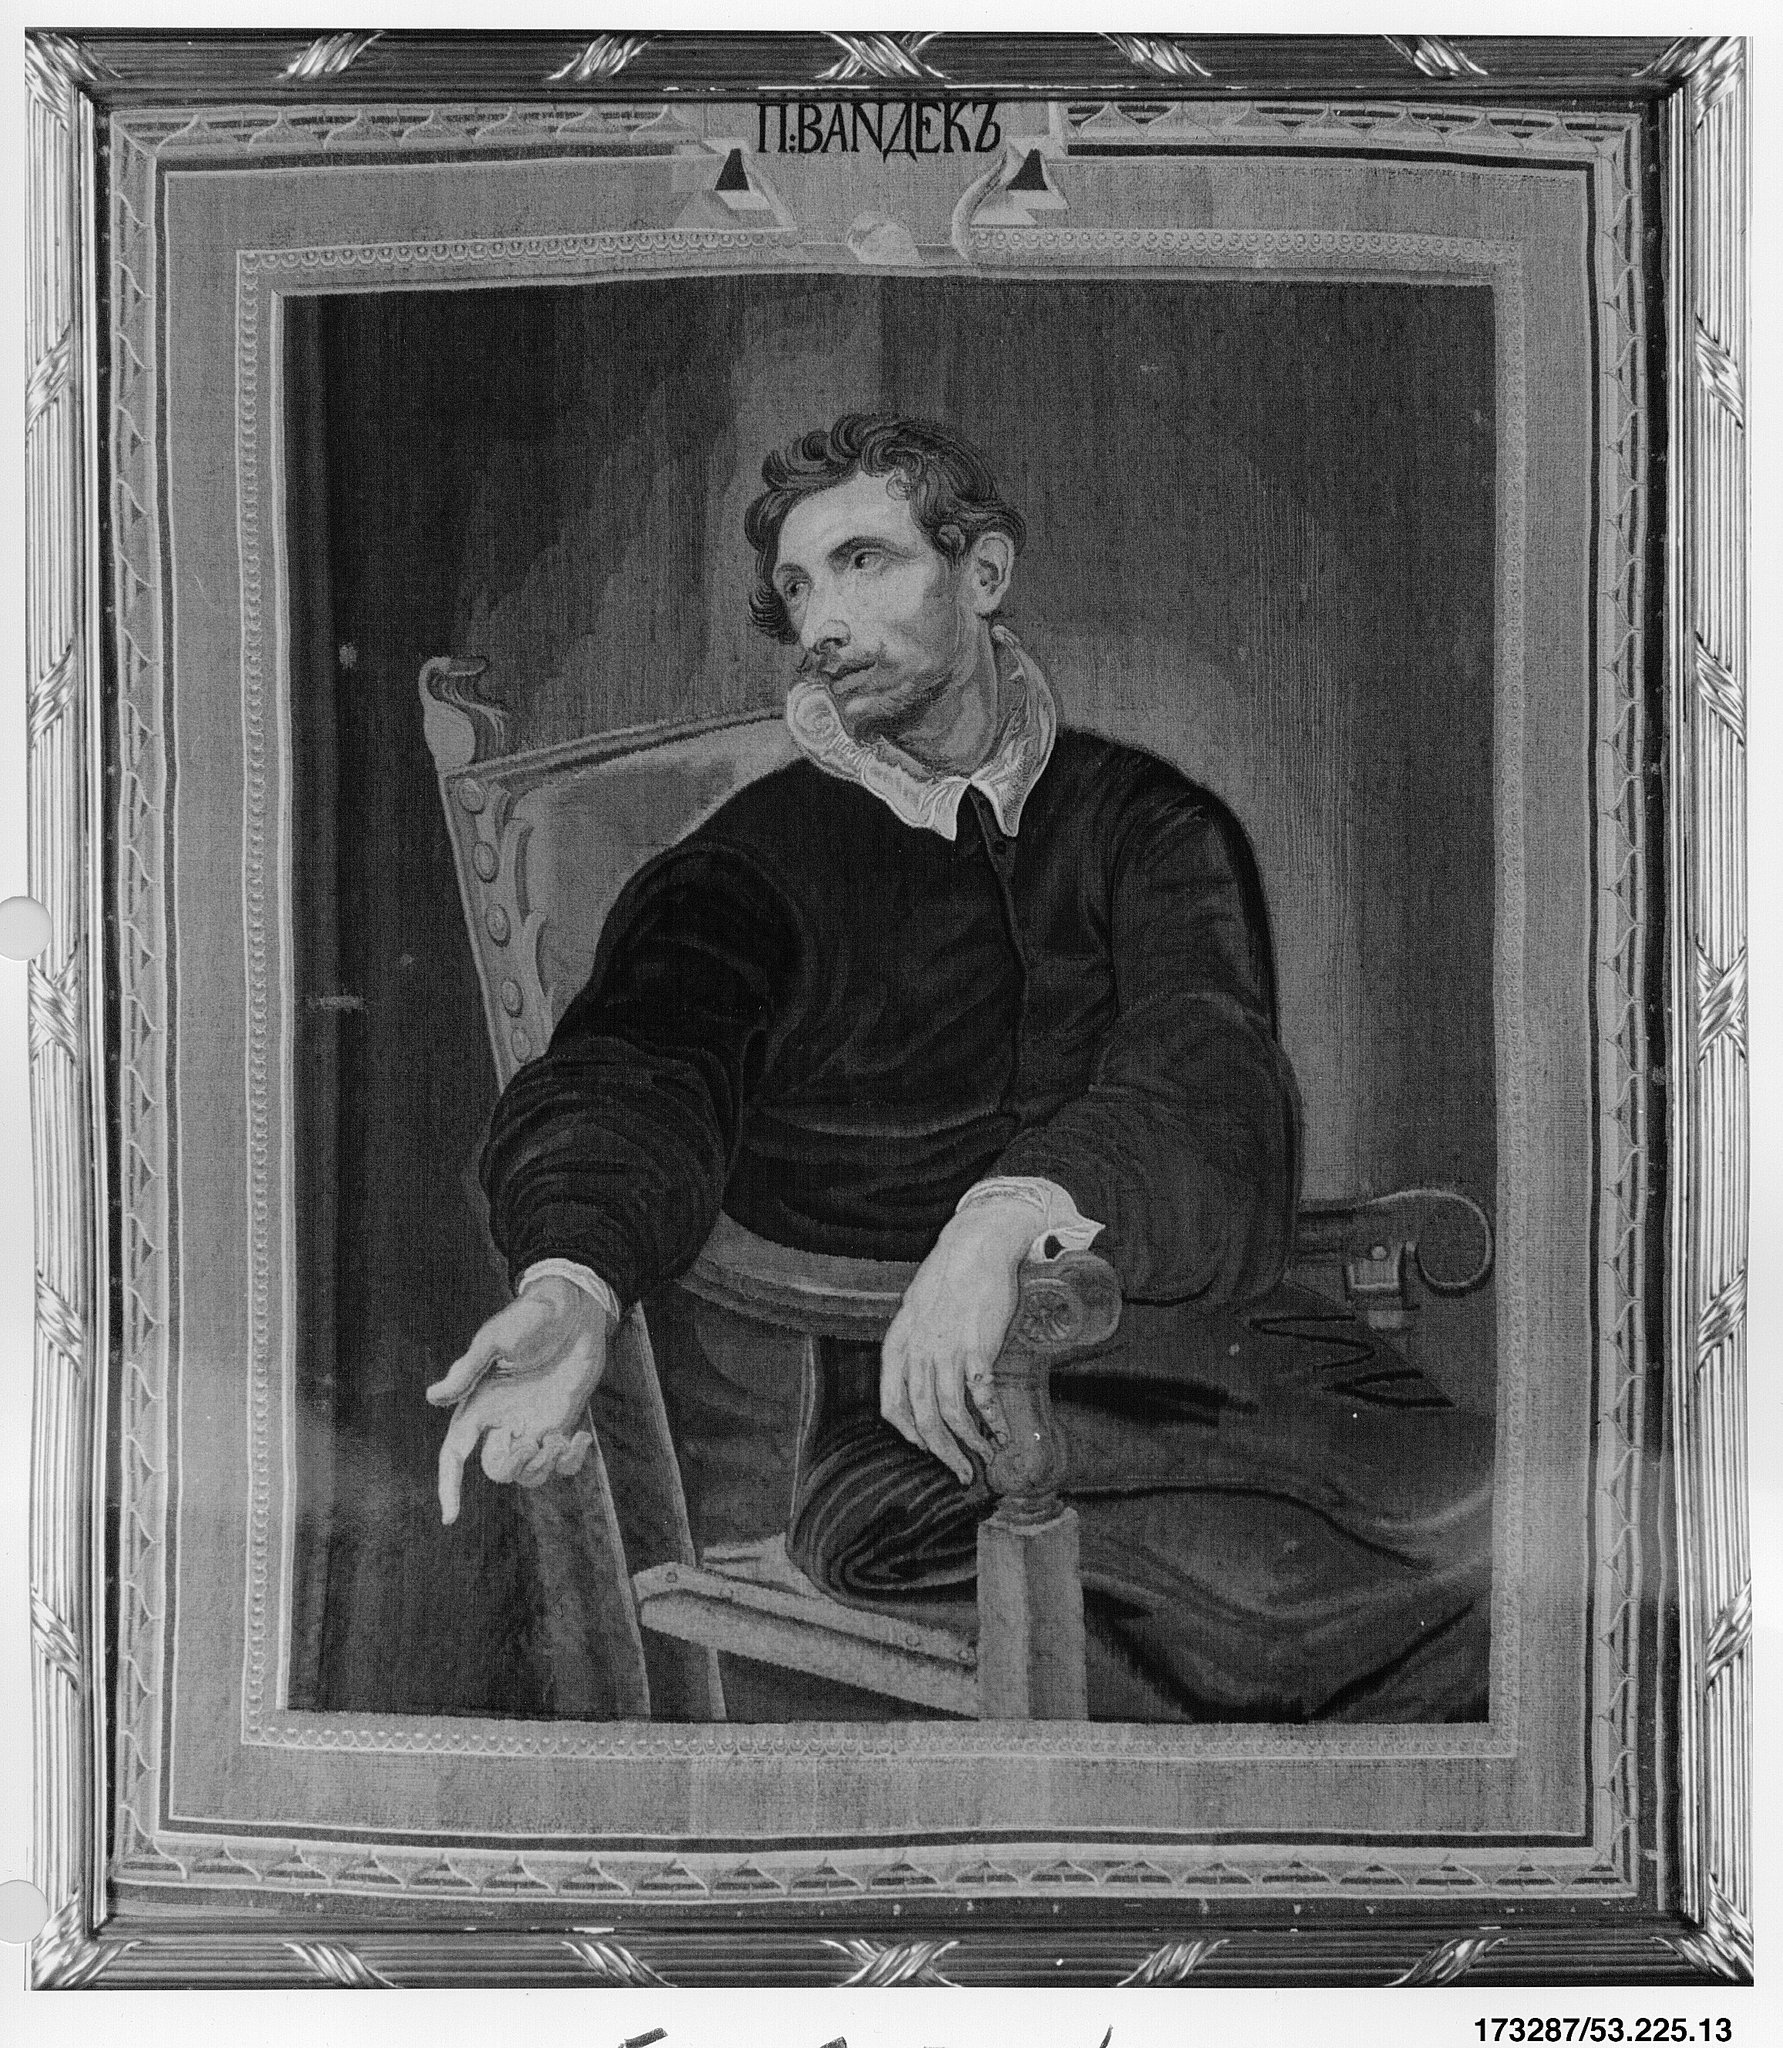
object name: tapestry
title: Dr. Lazarus Markijzus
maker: imperial russian tapestry manufactory, saint petersburg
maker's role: manufactory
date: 1767-1800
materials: metal thread, wool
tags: men